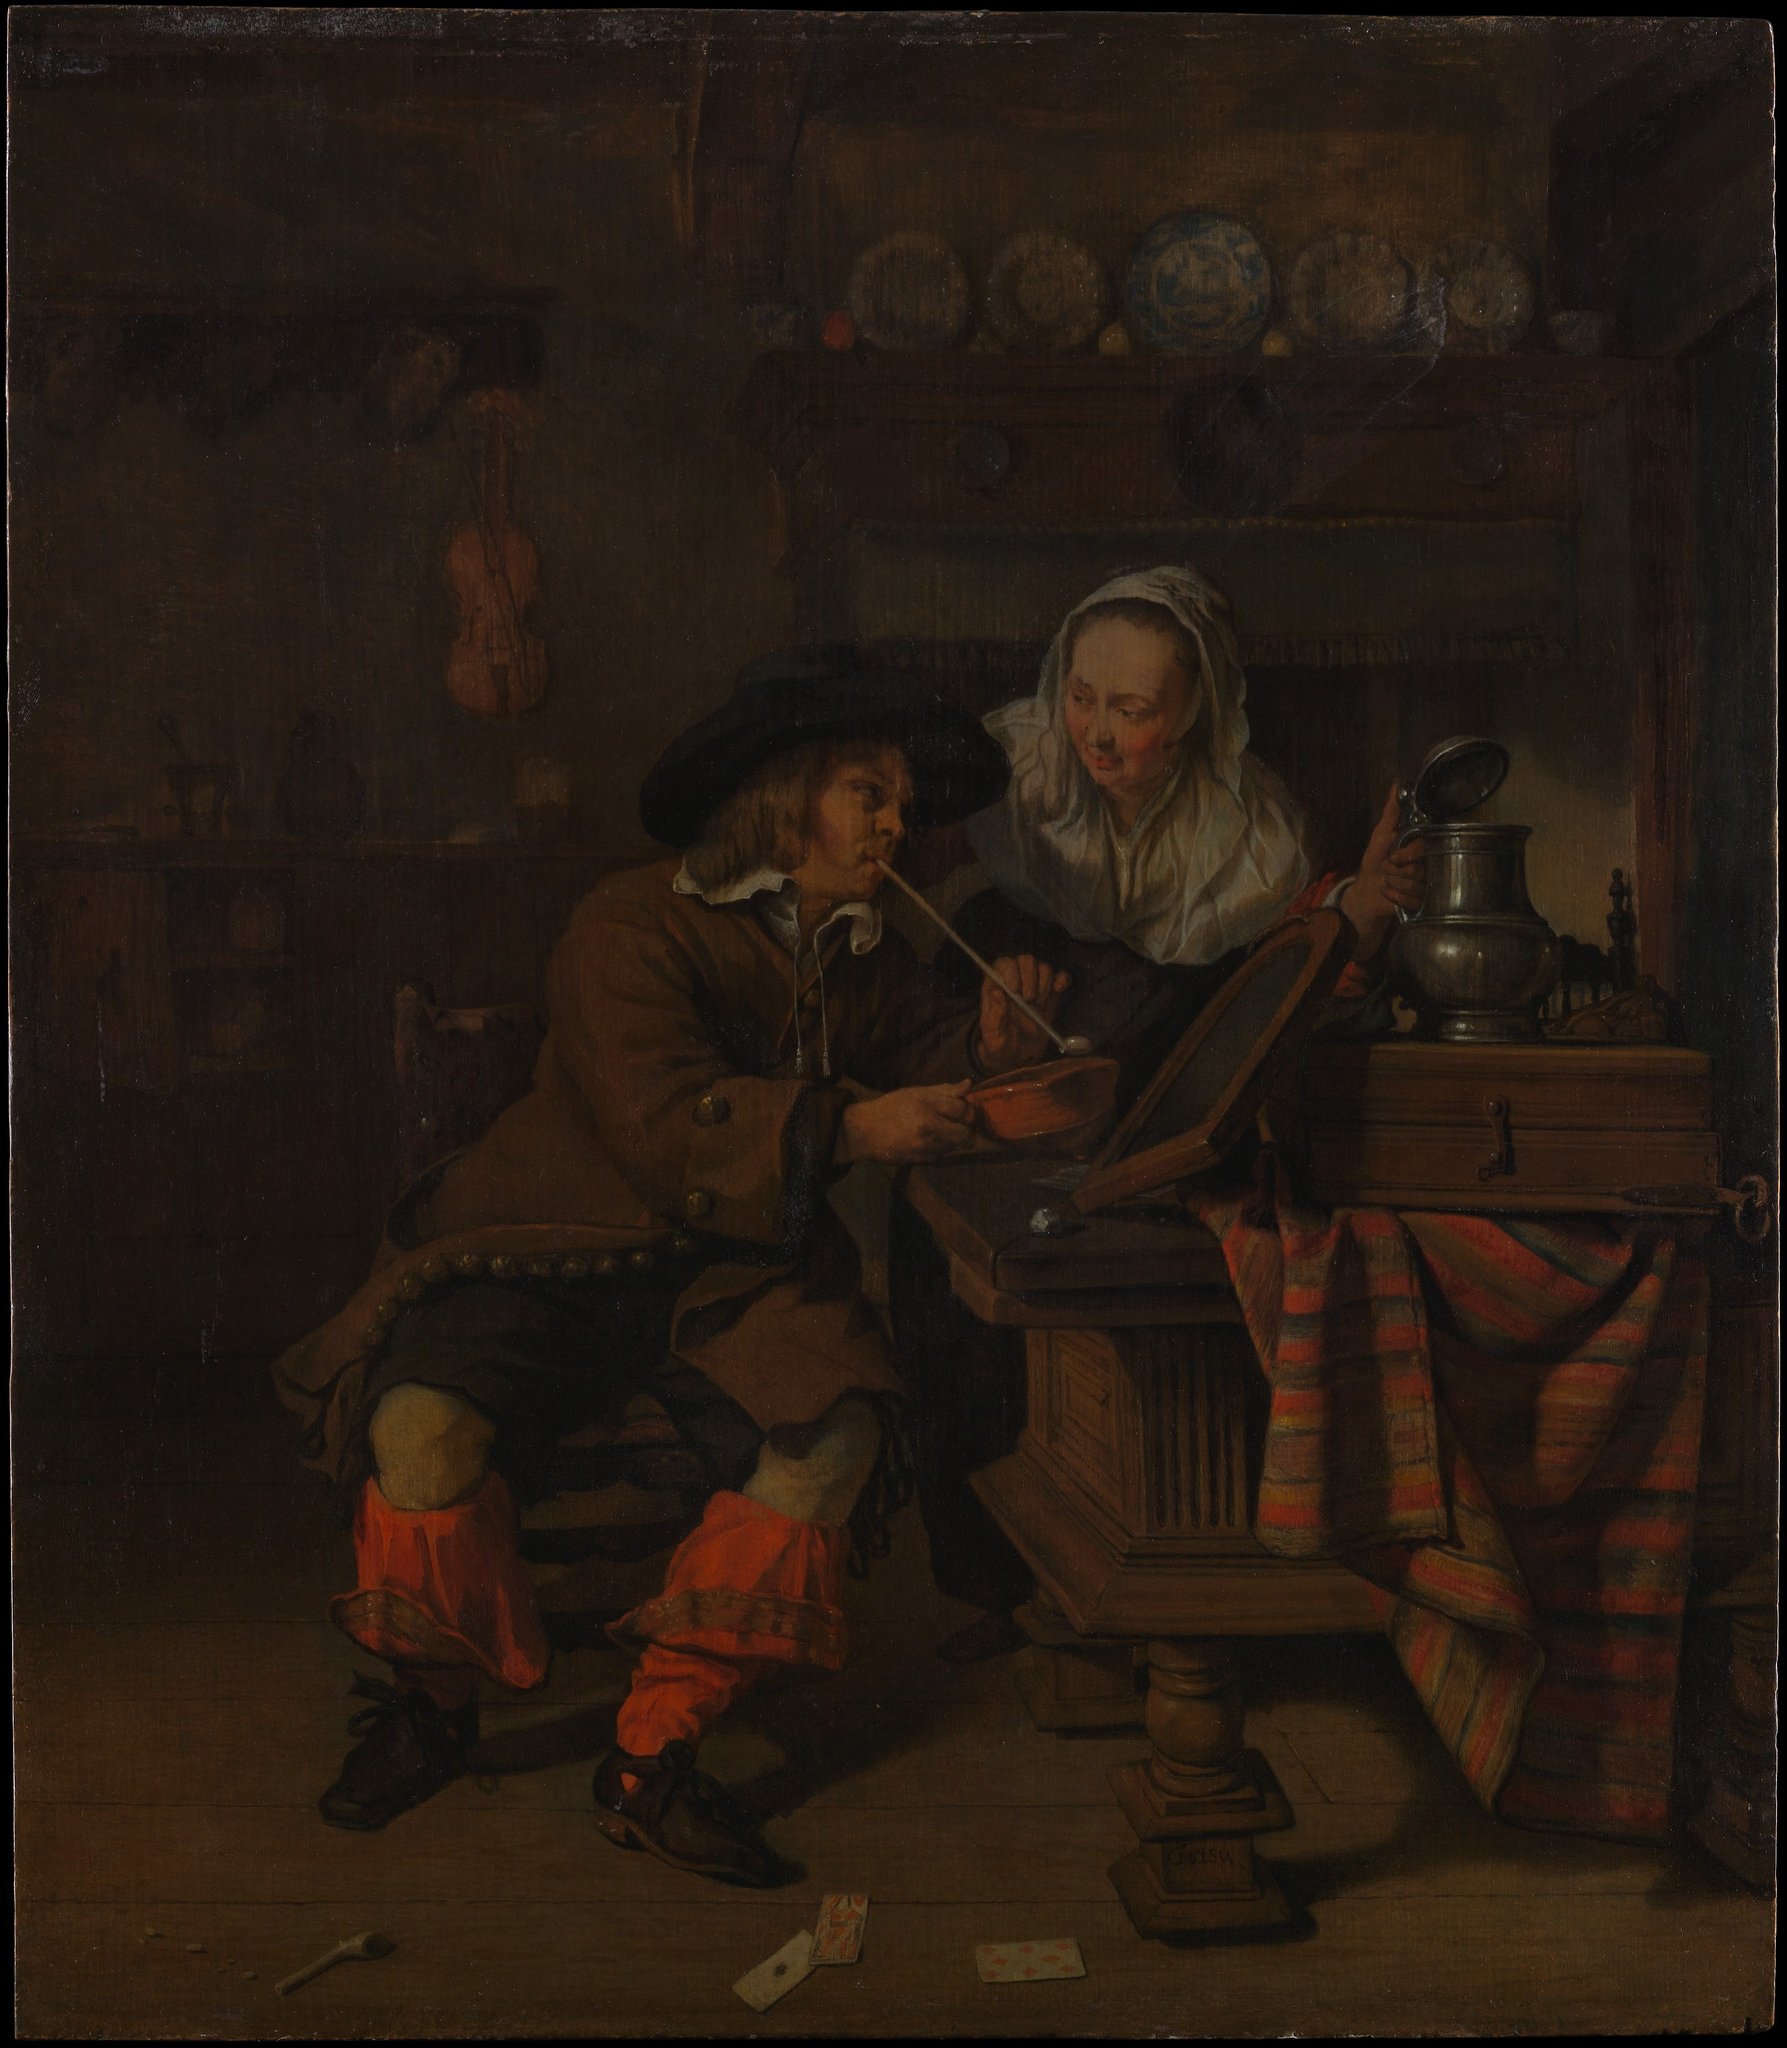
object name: painting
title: Tavern Scene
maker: gabriël metsu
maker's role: artist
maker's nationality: dutch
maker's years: 1629-1667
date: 1649-1667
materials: oil, wood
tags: musical instruments,taverns,men,women,smoking,drinking,genre scene